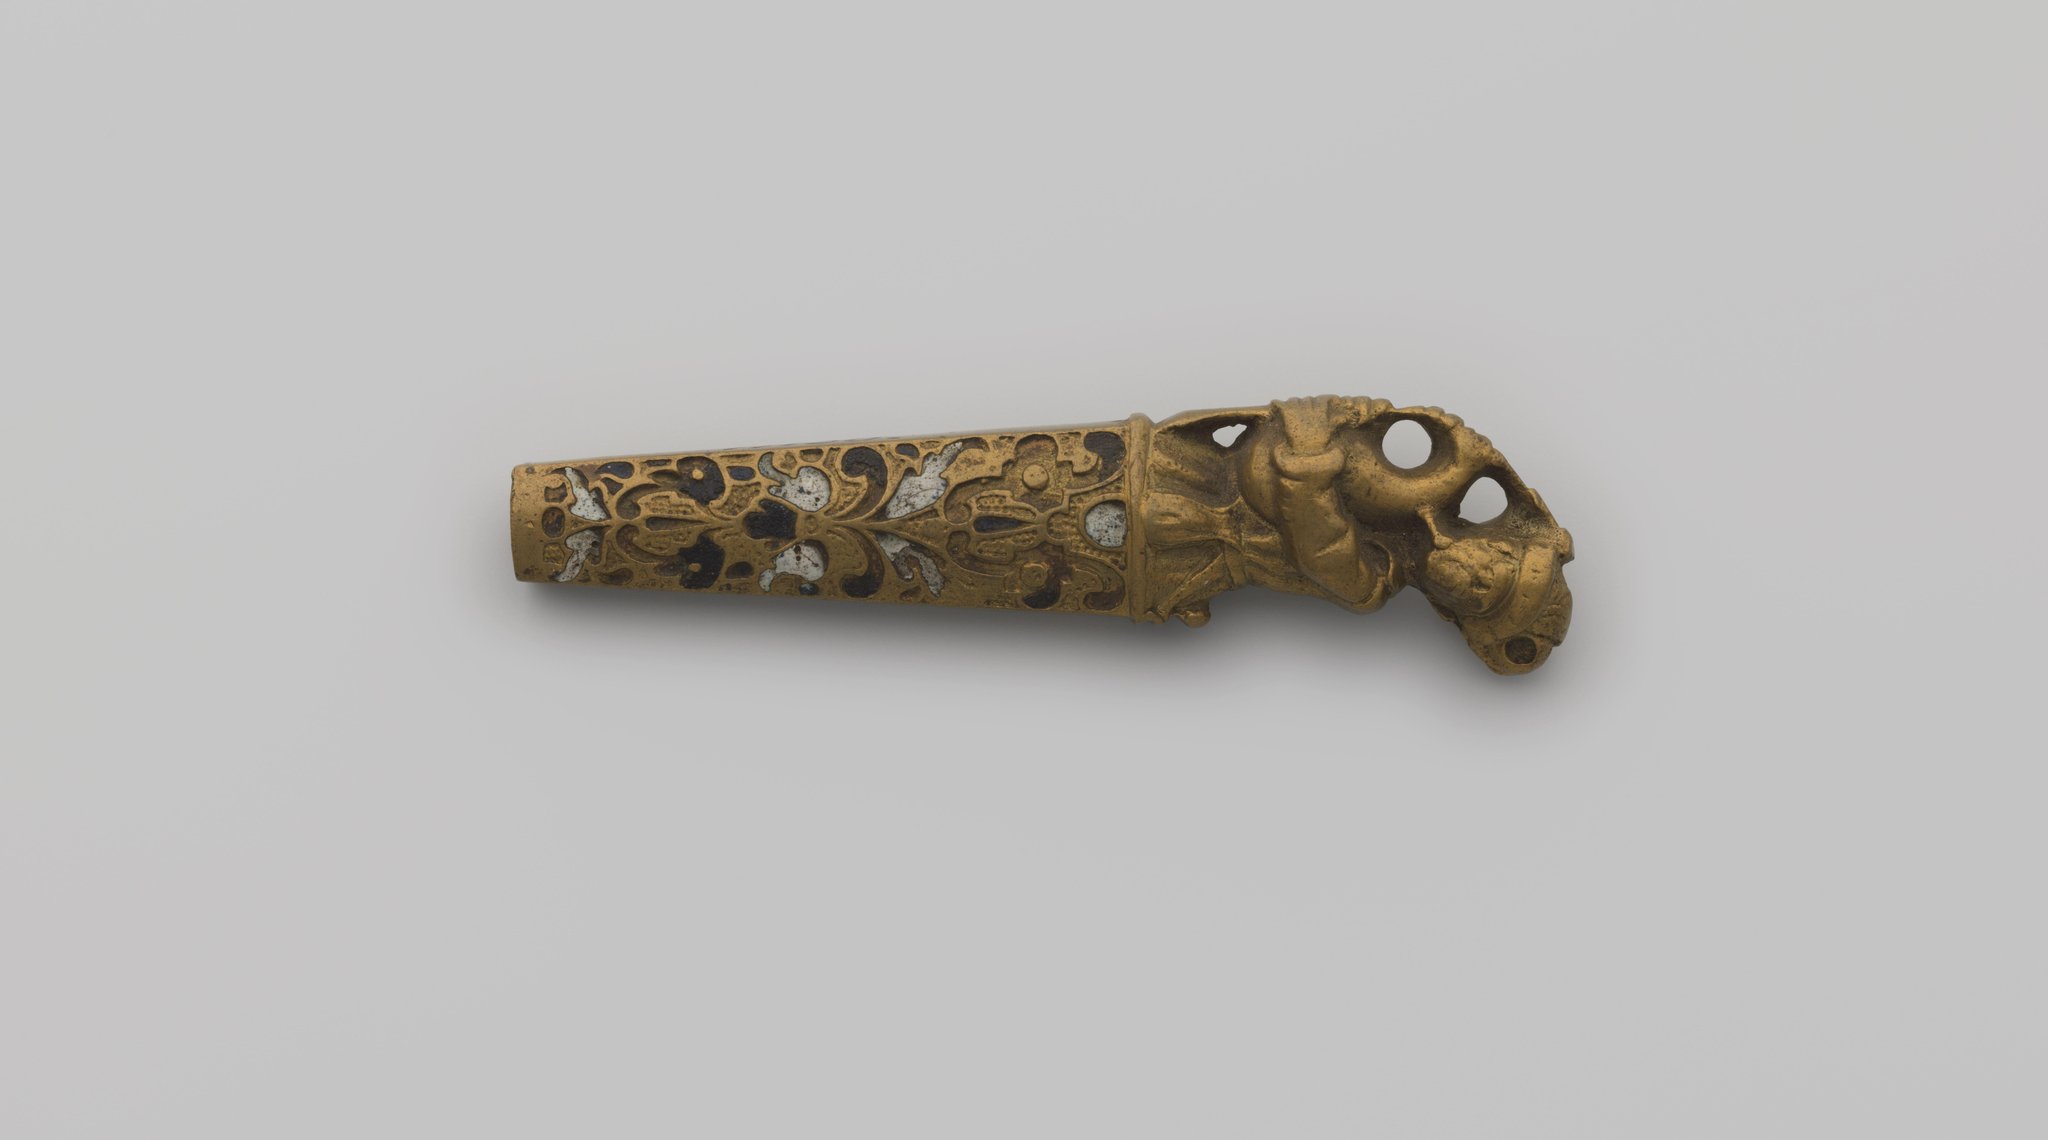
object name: knife handle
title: Messenheft van koper versierd met email en doedelzakspeler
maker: Anonymous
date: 1575-1625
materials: brass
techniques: enamel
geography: southern netherlands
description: Messenheft van koper versierd met bladmotieven van gekleurd email. De bekroning wordt gevormd door een doedelzakspeler.